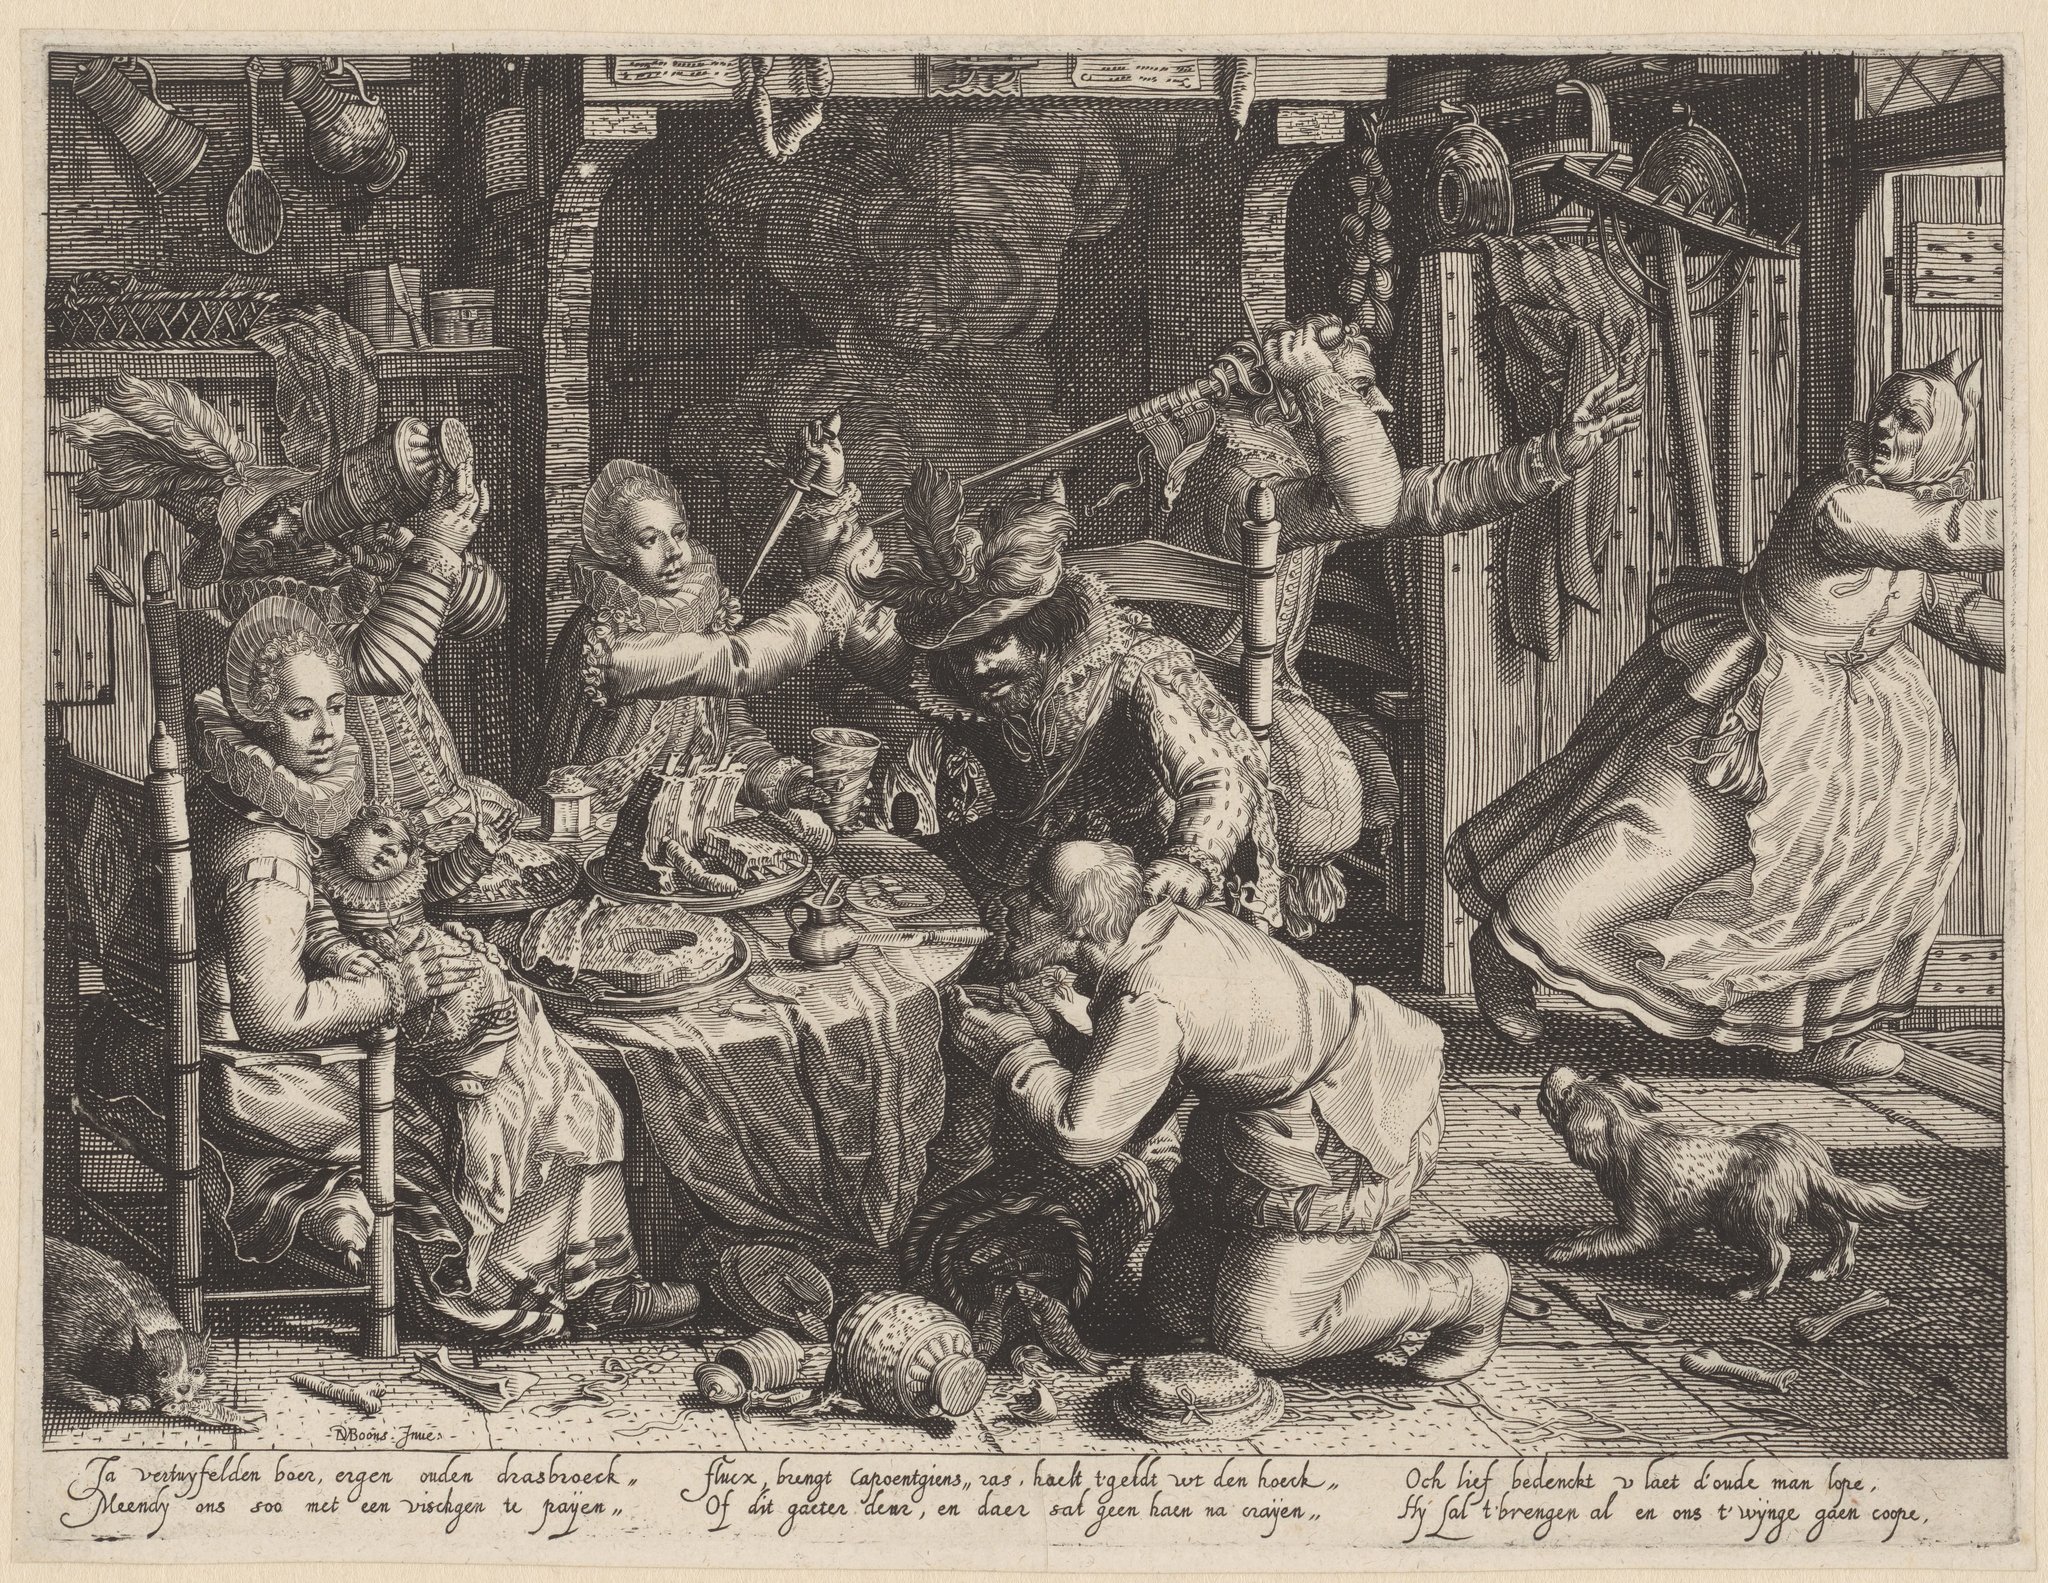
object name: print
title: Rijk gekleed gezelschap aan maaltijd bedreigt arme boer in zijn woning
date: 1610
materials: paper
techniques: engraving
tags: fight between farmers and soldiers, contrast between rich and poor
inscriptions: collector's mark: Lugt 240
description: Een gezelschap van twee dames en twee heren, rijk gekleed, gebruiken een maaltijd aan tafel in een boerenwoning die ze hebben 'bezet'. Een oude boer, die op zijn knieën voor de tafel zit, wordt bedreigd met een mes en gesommeerd meer voedsel en wijn te brengen. De oude boerin wordt door een van de heren met een degen het huis uitgejaagd. Onder de voorstelling staat een spottend Nederlands vers.